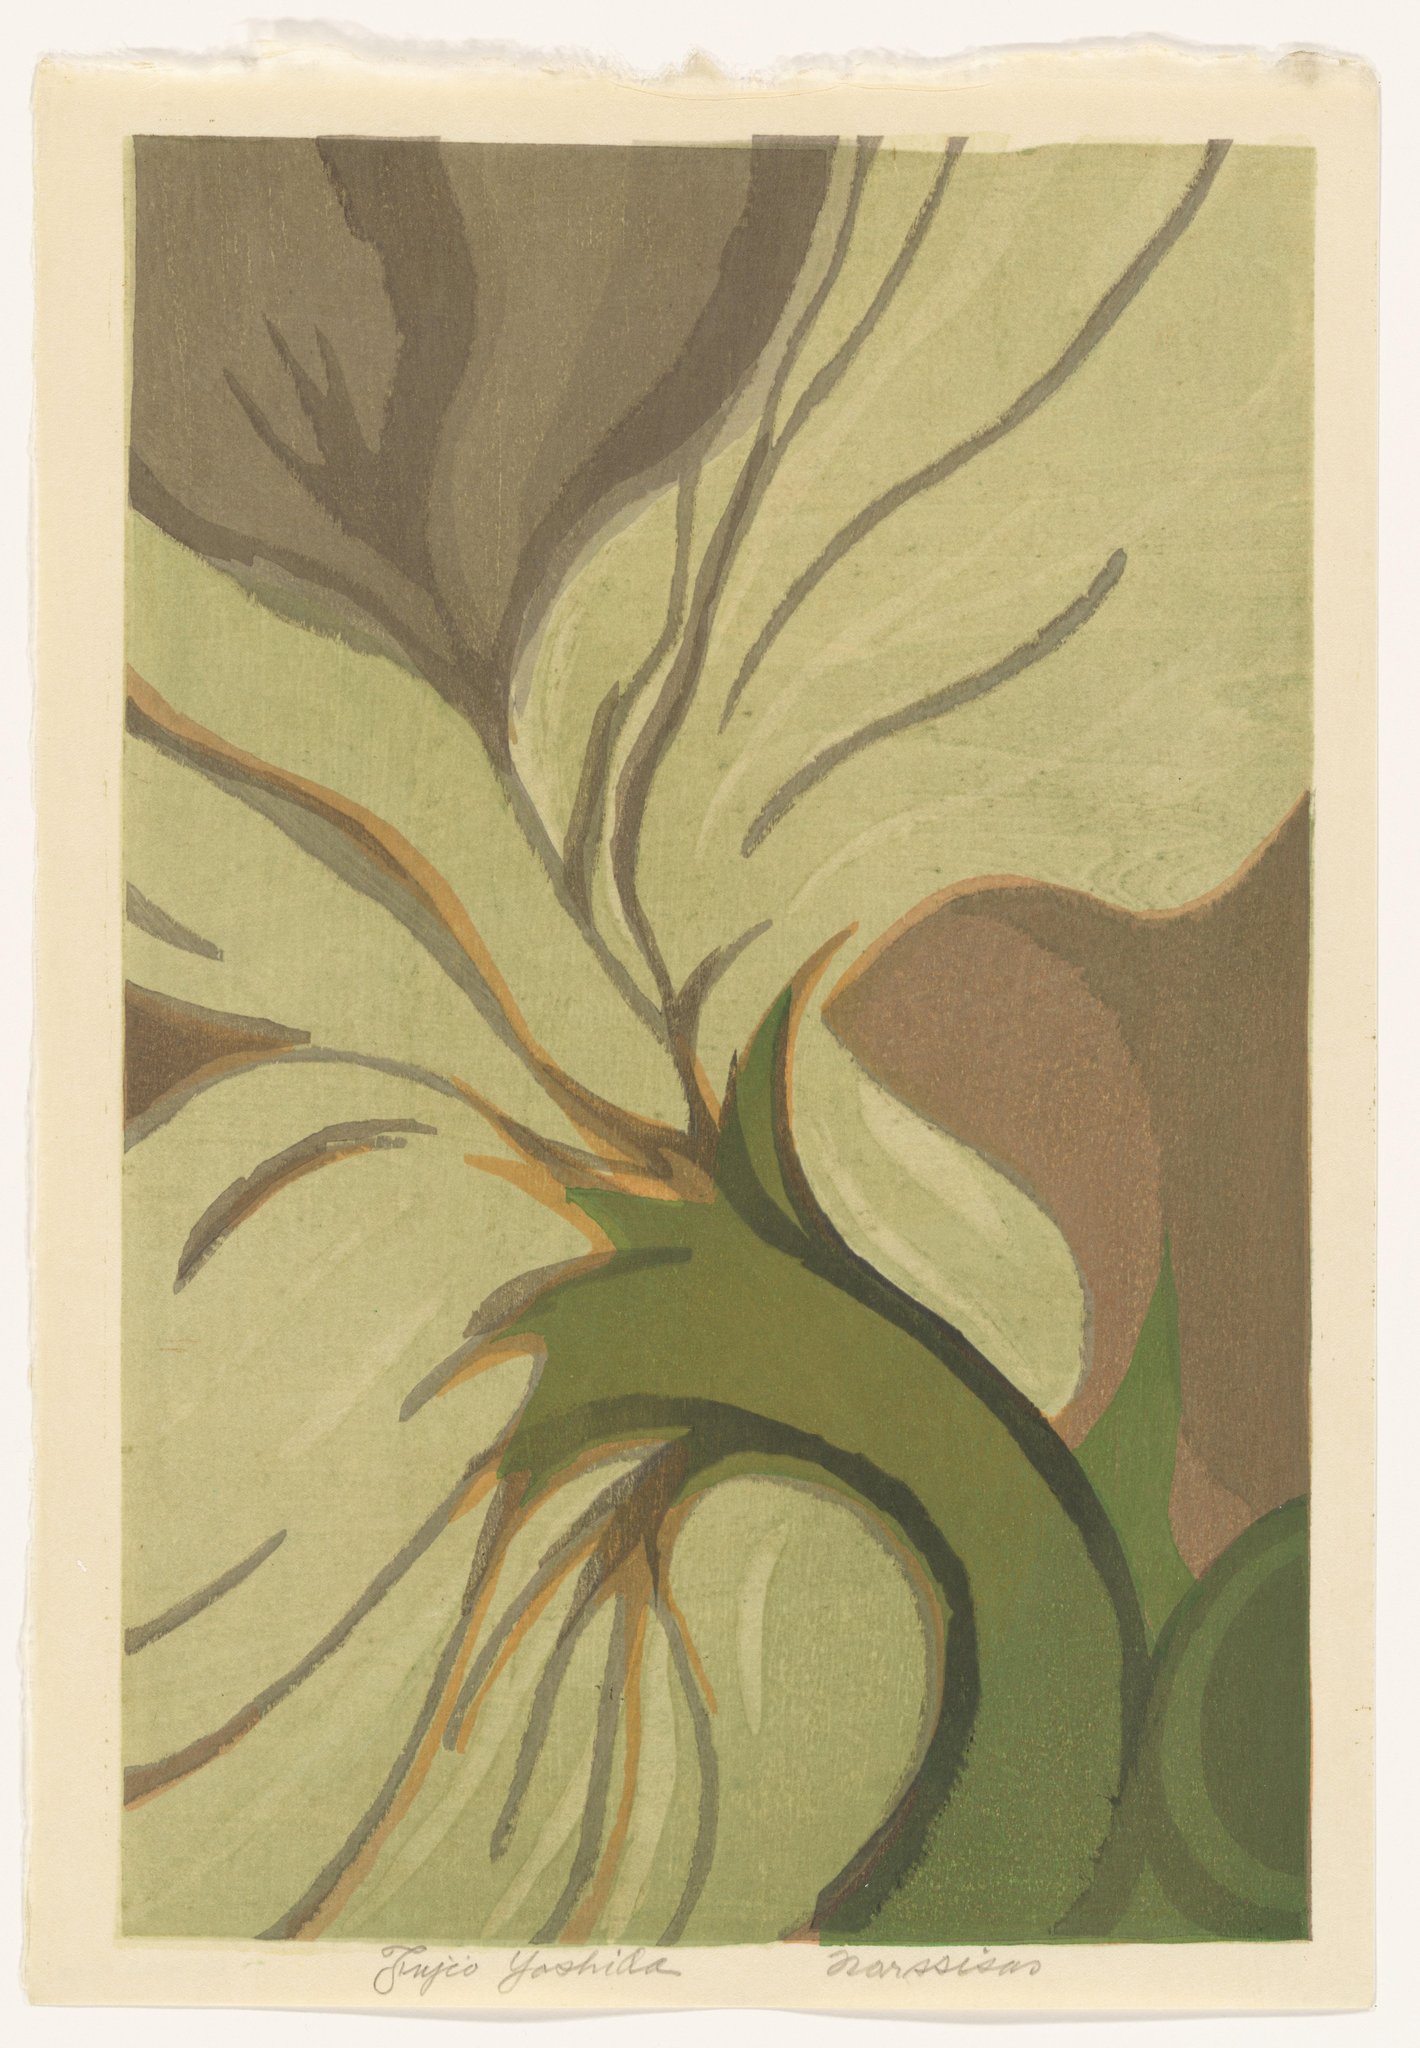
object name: print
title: Narcissus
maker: fujio yoshida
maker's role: painter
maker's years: 1887-1987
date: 1953-1954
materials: paper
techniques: woodcut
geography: japan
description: Fujio Yoshida worked in a figurative style for a long time, but after the death of her husband felt free to create more abstract work. These prints feature organic forms based on flowers and plants. Yoshida was also committed to the Shuyokai, the first association for women painters in Japan, which provided training and opportunities for exhibiting their paintings.